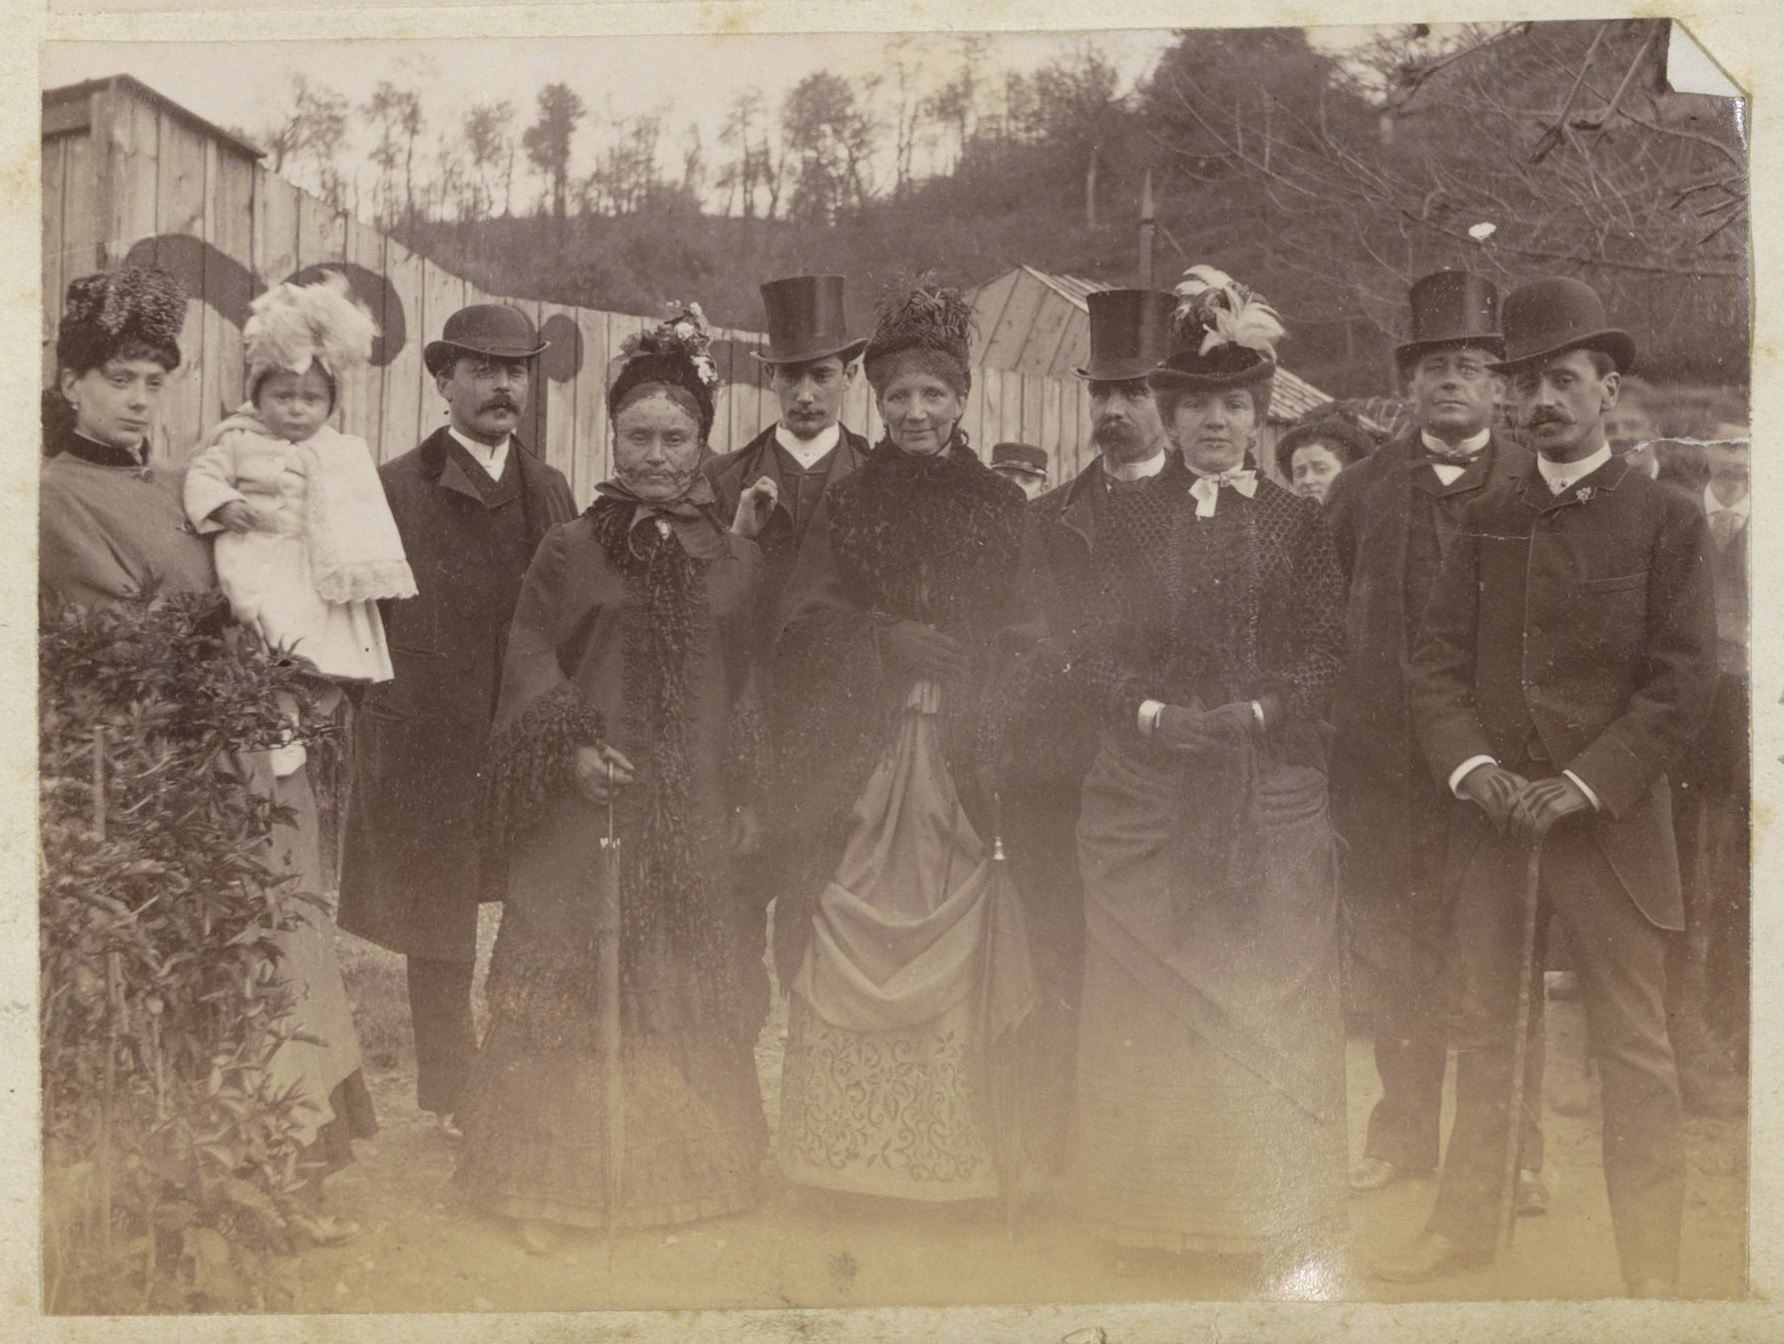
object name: photograph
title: Groepsportret van een Franse familie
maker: Anonymous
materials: photographic support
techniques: albumen print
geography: france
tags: three generations (family group)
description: Onderdeel van Album van een Franse amateurfotograaf met opnames van familie, militairen, industrie, landschappen en bezienswaardigheden in Frankrijk.